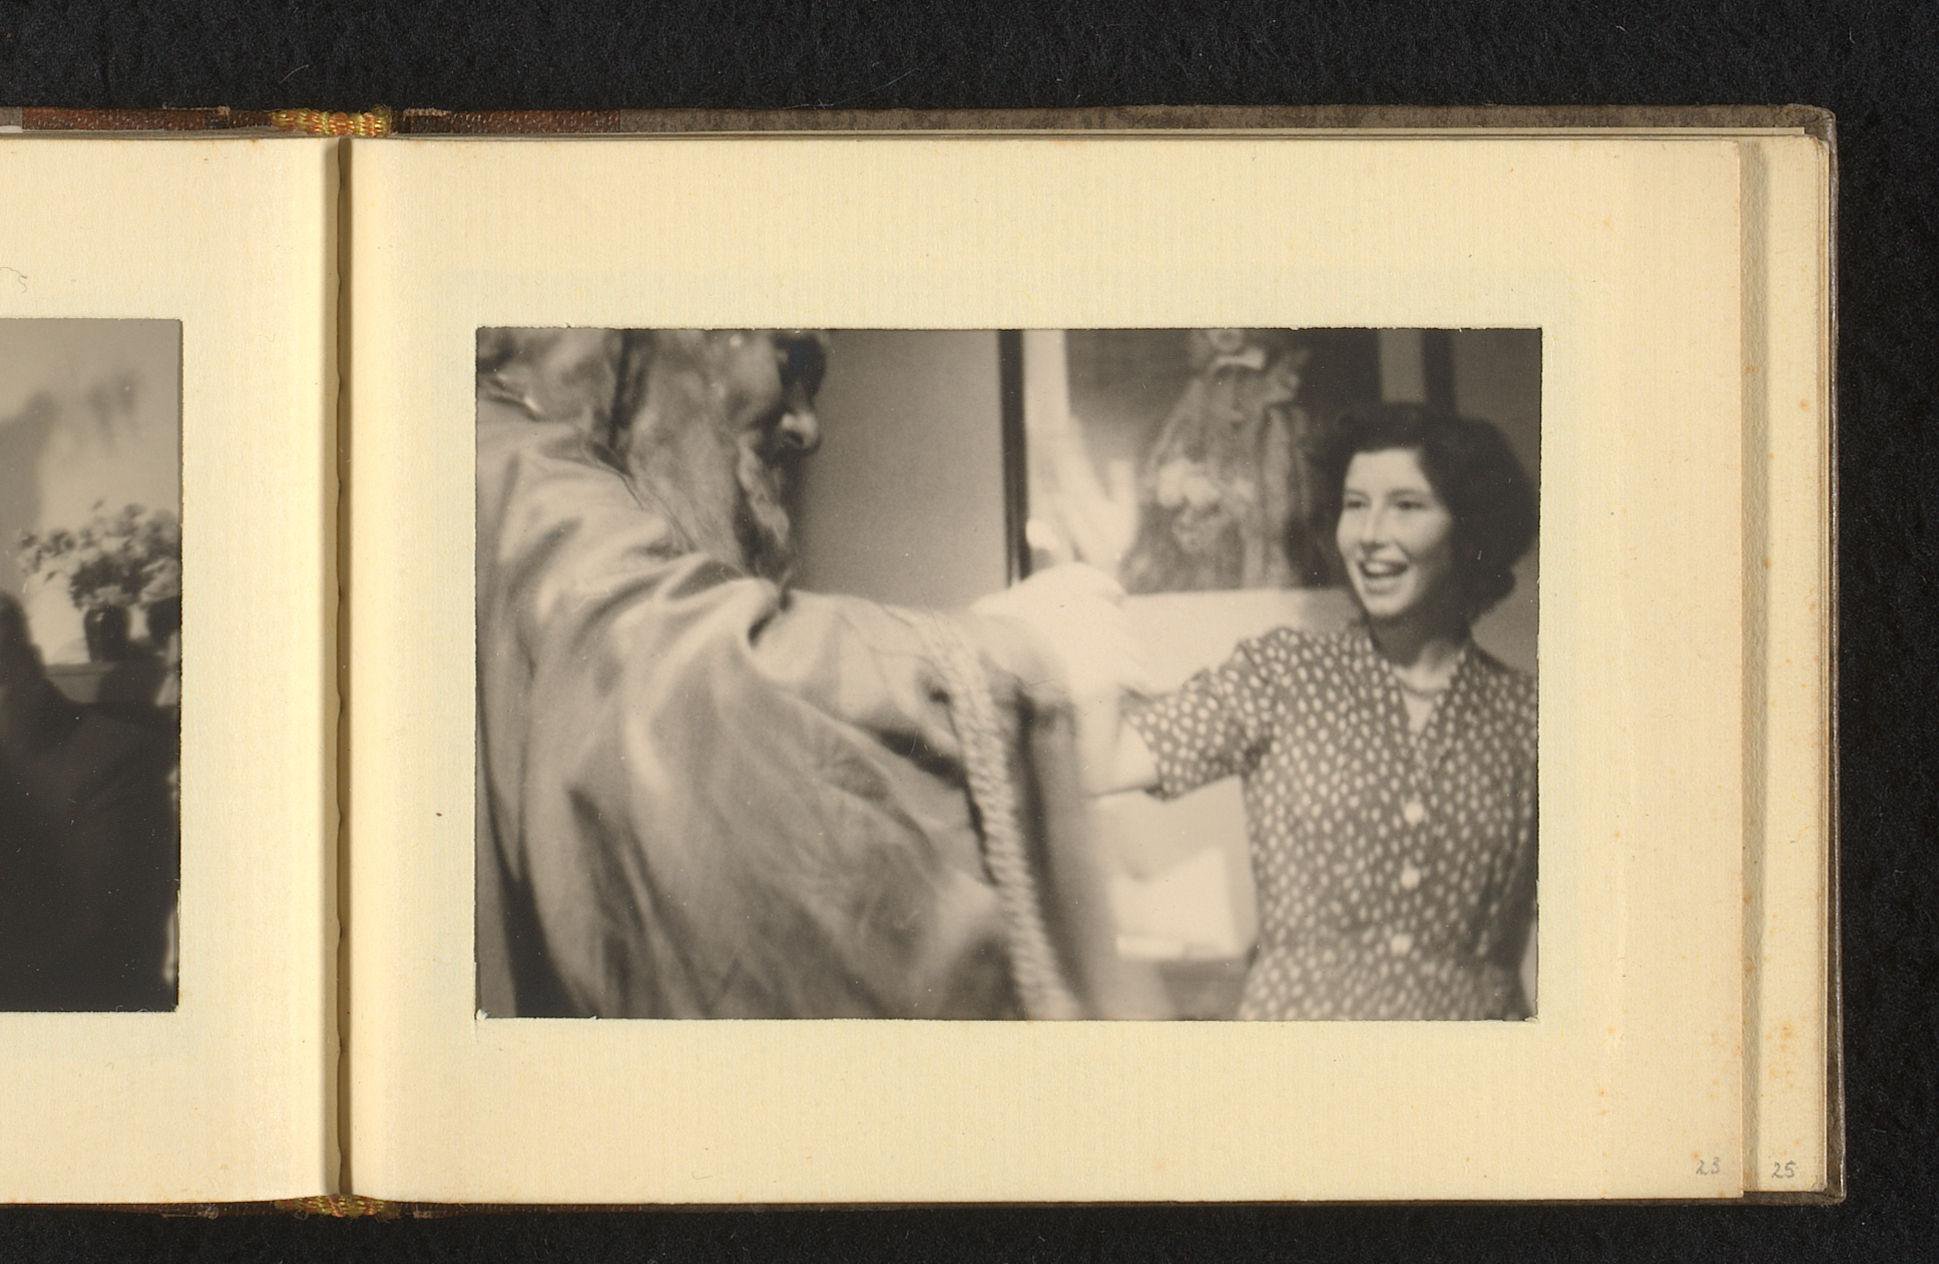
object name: album leaf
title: Sinterklaas en een vrouw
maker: norbert van den berg (1901-1972)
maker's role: amateurfotograaf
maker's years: 1901-1972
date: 1935-1950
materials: paper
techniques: gelatin silver print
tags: adult woman, festivities on st. nicholas (eve) (december 5), saint nicholas day